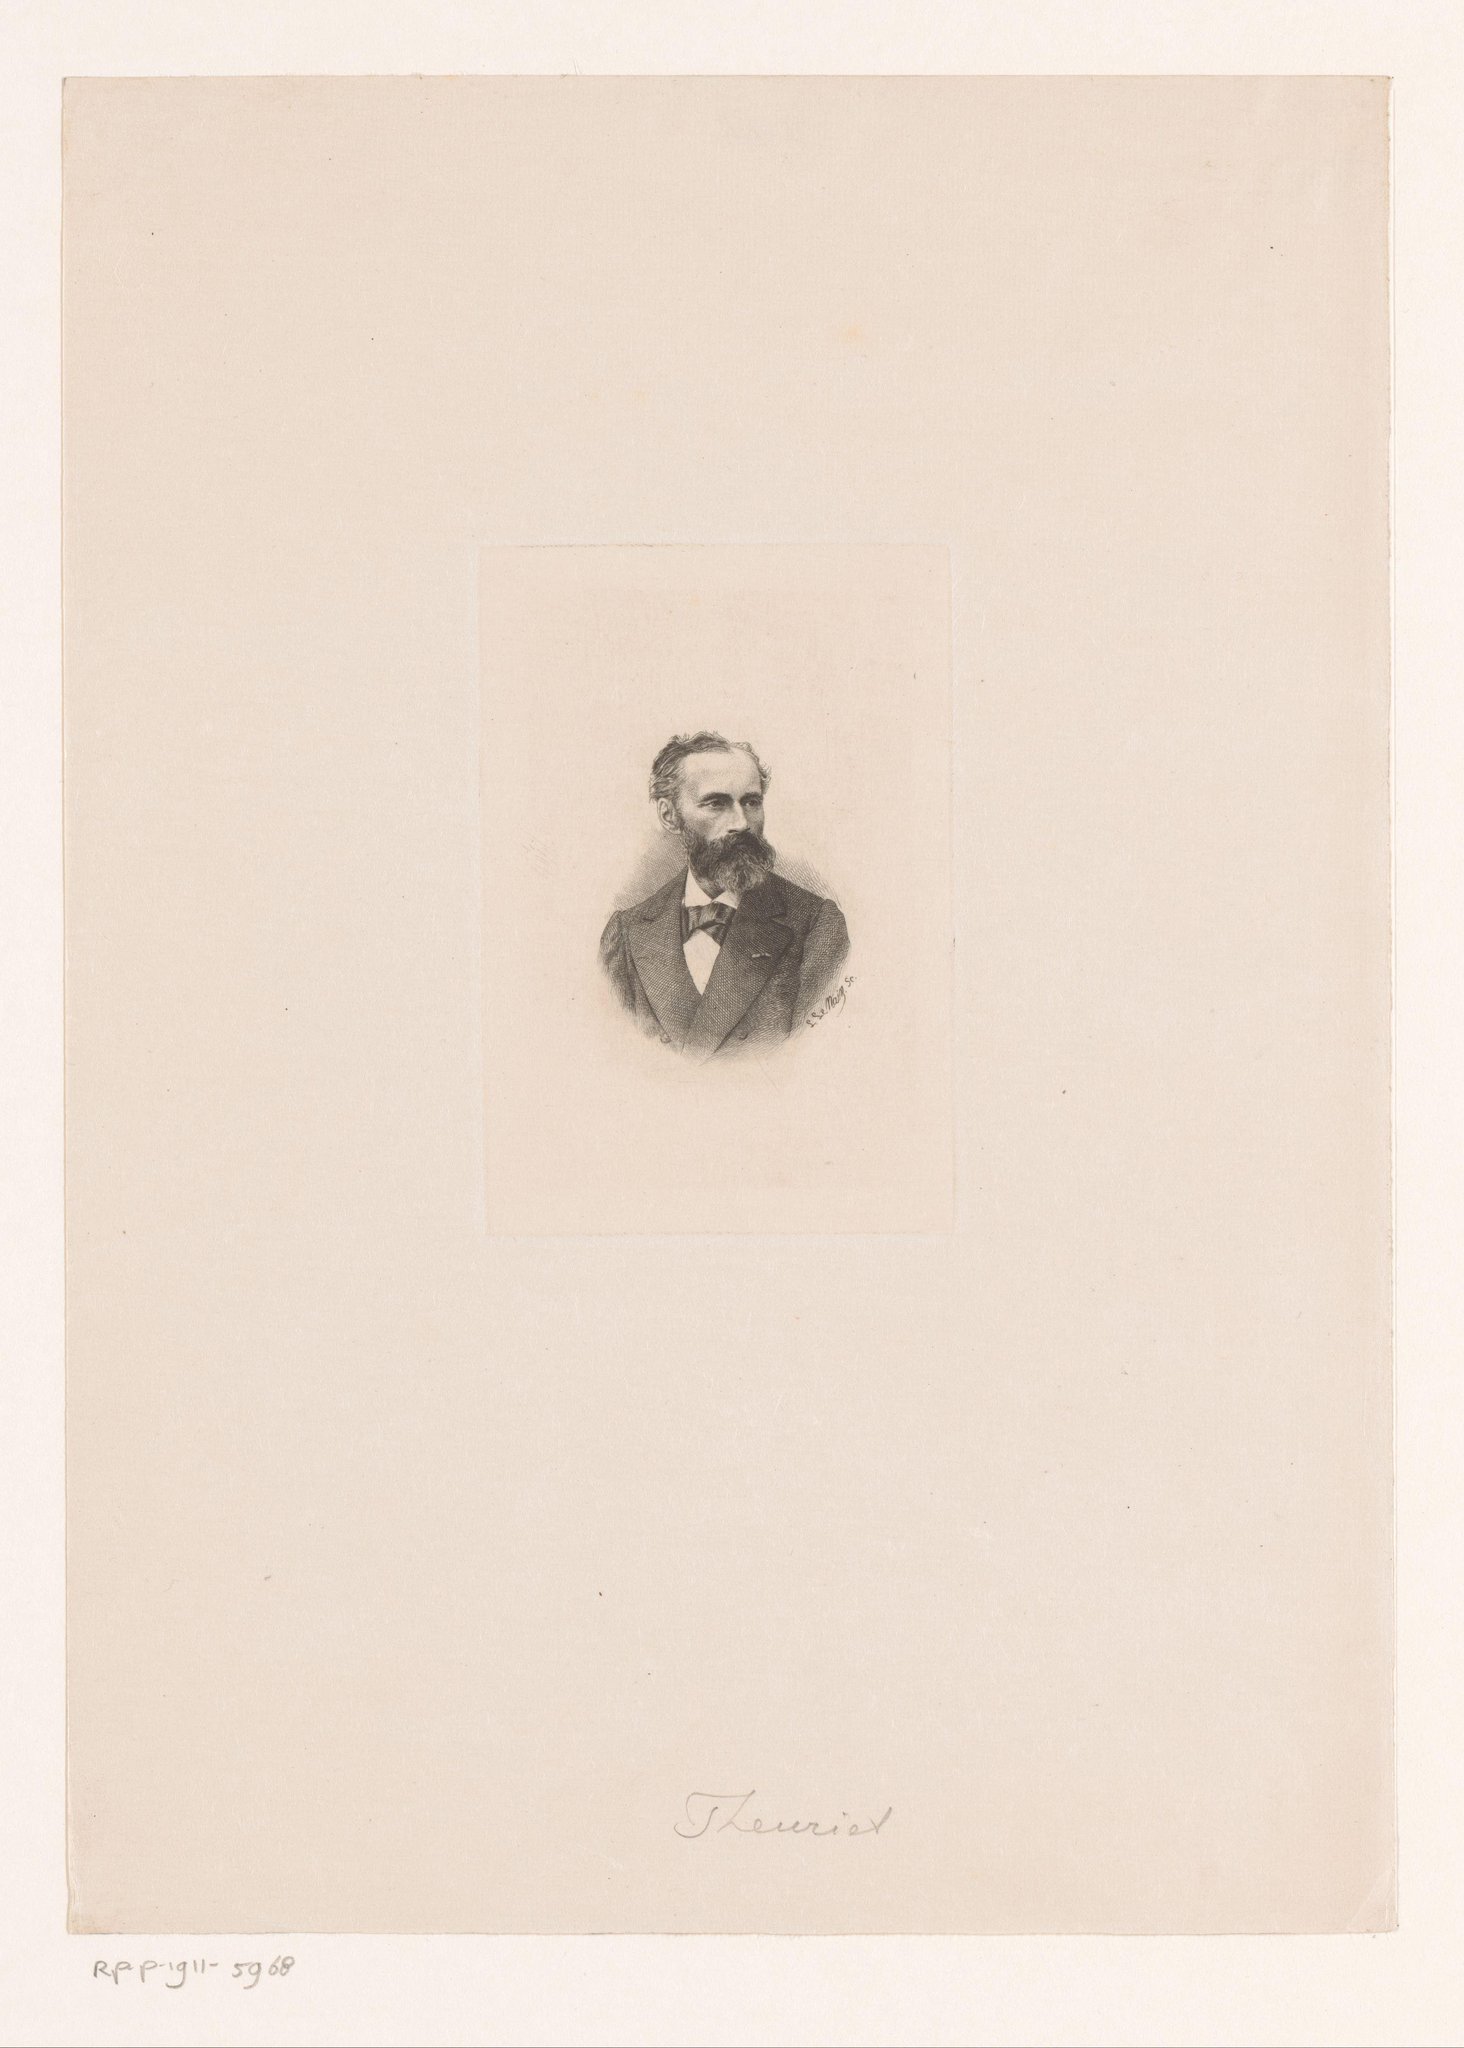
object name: print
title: Portret van André Theuriet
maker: louis le nain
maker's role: print maker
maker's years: 1851-1939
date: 1861-1911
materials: paper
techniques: etching, intaglio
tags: adult man, historical persons, beard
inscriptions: collector's mark: Lugt 2228